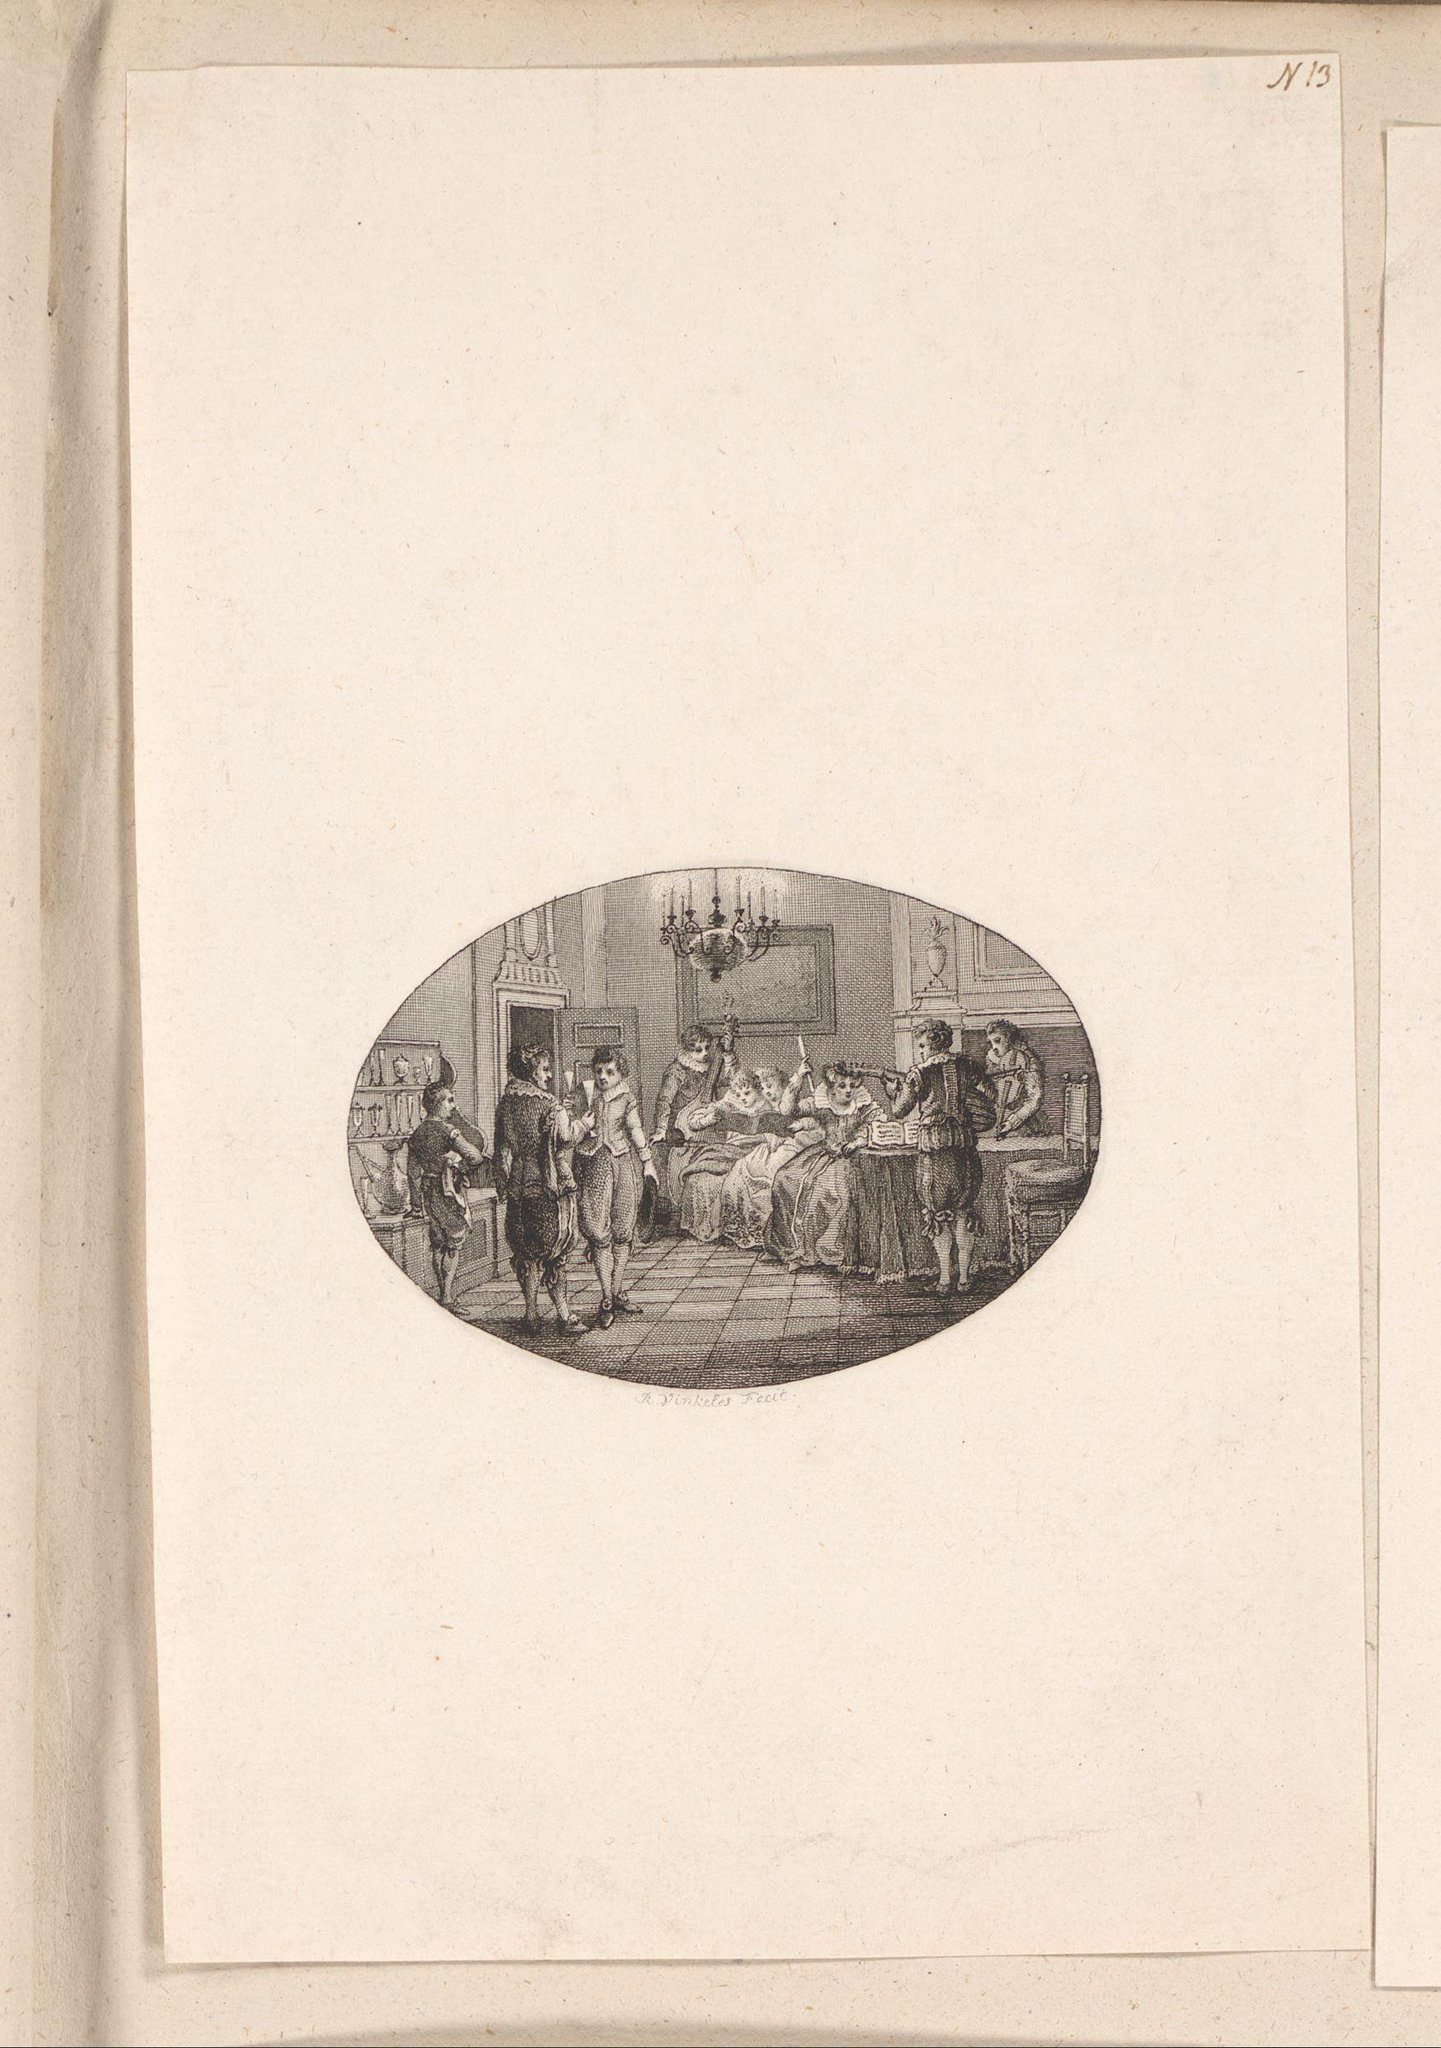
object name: titelblad, titelpagina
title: Titelpagina voor: Adriaan Pietersz. Loosjes, Het Leven van Maurits Lijnslager, 1808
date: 1808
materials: paper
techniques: engraving, etching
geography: amsterdam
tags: instrumental and vocal music together, banquet of elegant company (+ toast at meal, banquet)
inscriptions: inscription: ‘N 13’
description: Proefdruk van de titelpagina voor: Loosjes, Adriaan Pietersz. Het leven van Maurits Lijnslager: eene Hollandsche familiegeschiedenis uit de zeventiende eeuw. Haarlem: Adriaan Pietersz. Loosjes, 1808.